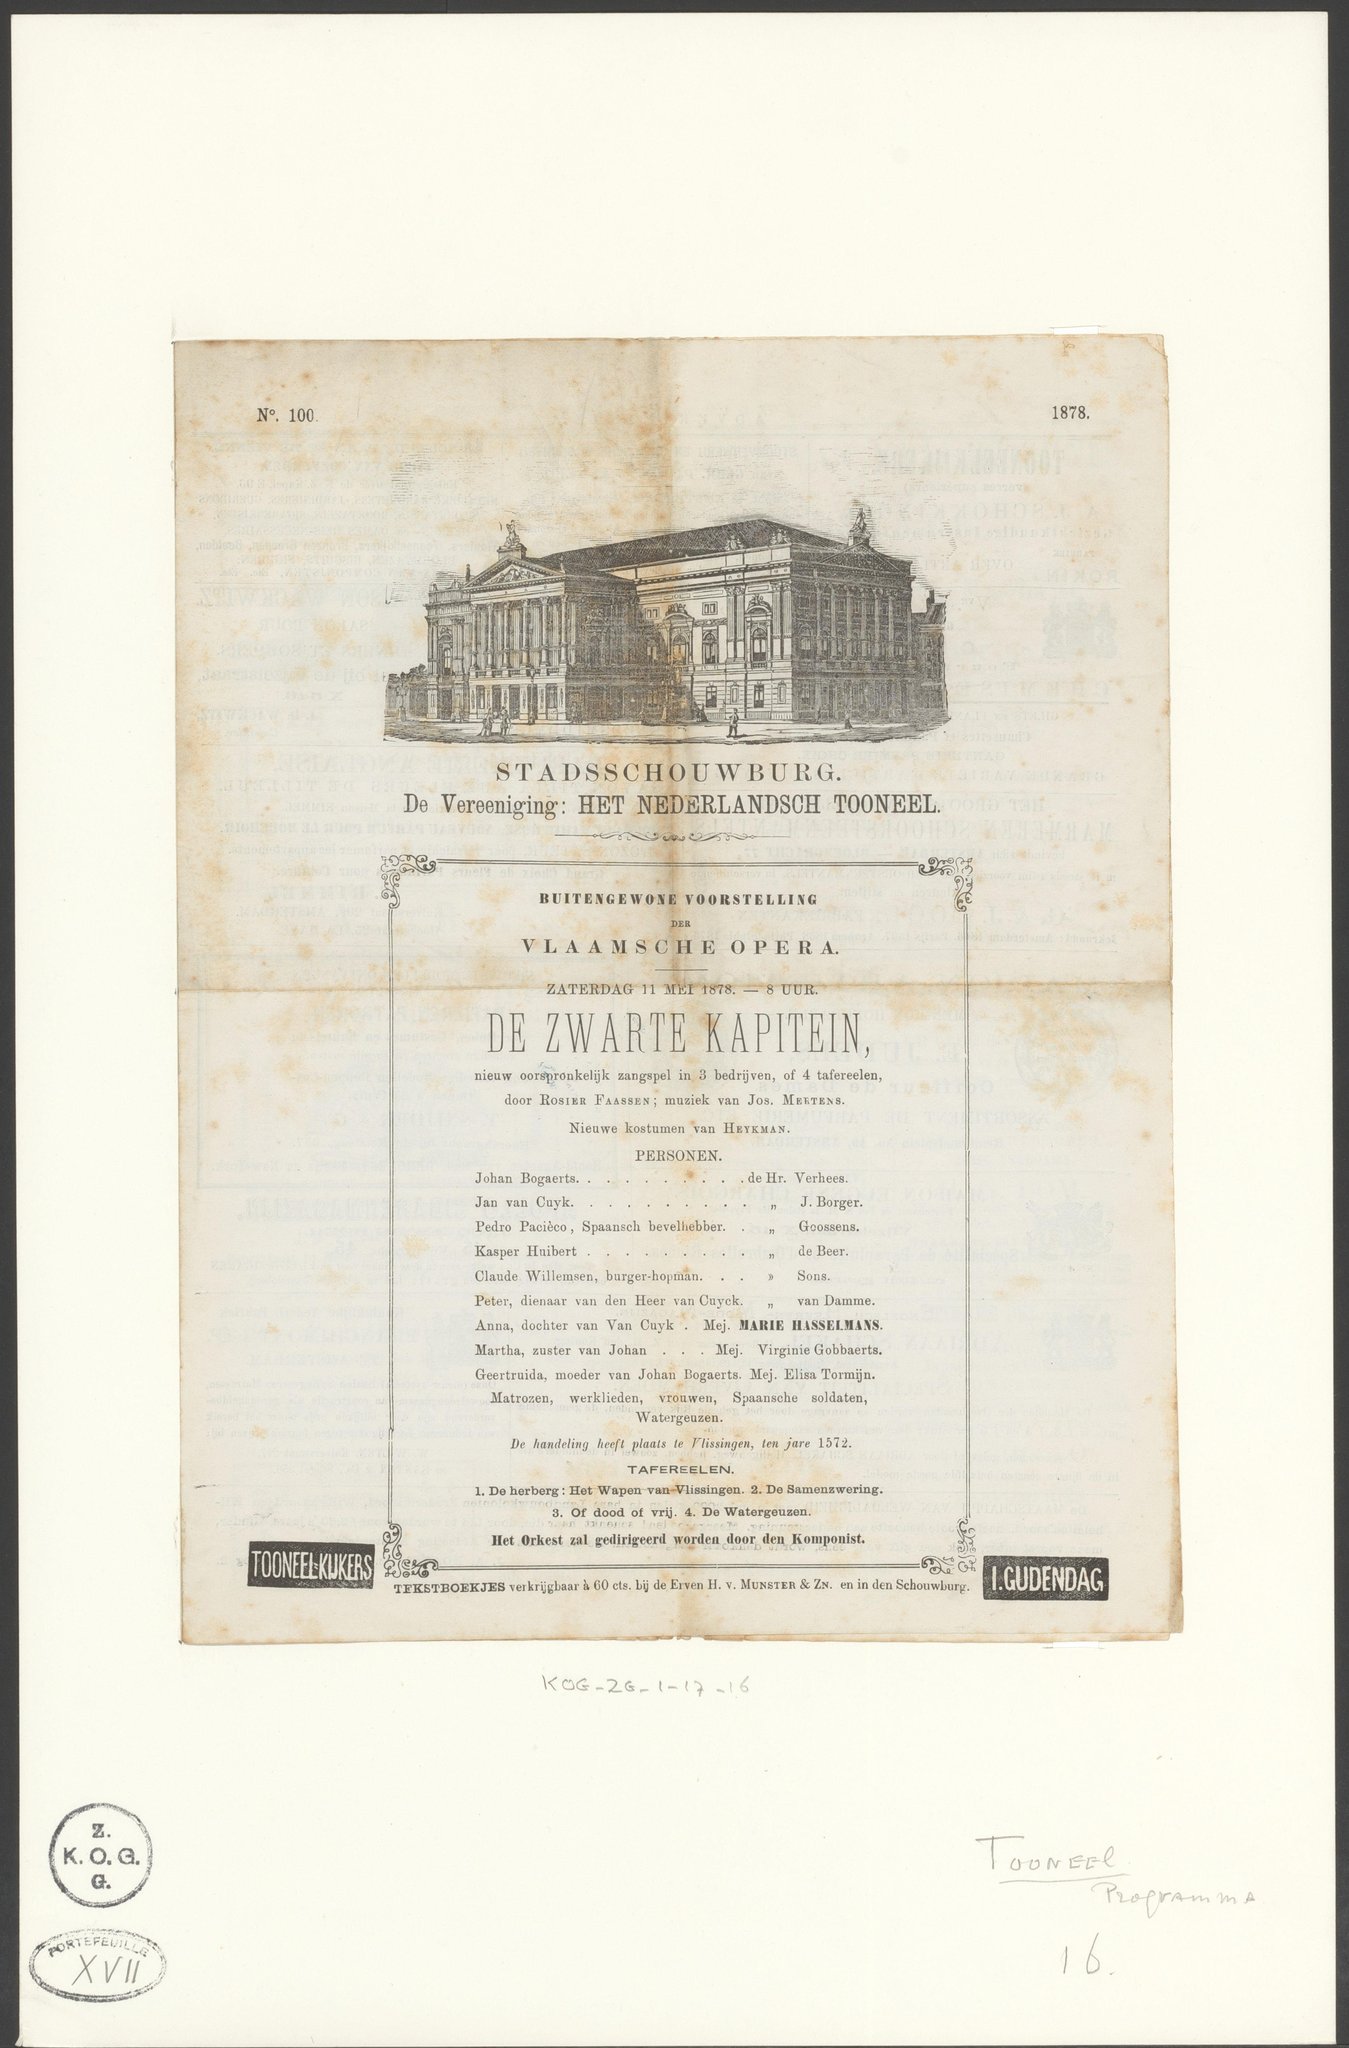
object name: print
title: Aankondiging voor de voorstelling De Zwarte Kapitein in de Stadsschouwburg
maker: Anonymous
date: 1878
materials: paper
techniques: letterpress printing, engraving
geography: amsterdam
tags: theatre, theatrical performance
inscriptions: stamp, collector's mark: Lugt 1641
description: Aankondiging voor de voorstelling De Zwarte Kapitein in de Stadsschouwburg. Rechtsboven genummerd: No. 100. Het object bestaat uit een gevouwen blad die vier pagina's vormt. Op de voorpagina de aankondiging en op de andere drie pagina's advertenties. Onderwerpsrubrieken binnen de Atlas Zeden en Gewoonten: Tooneel, Toneelprogramma’s.